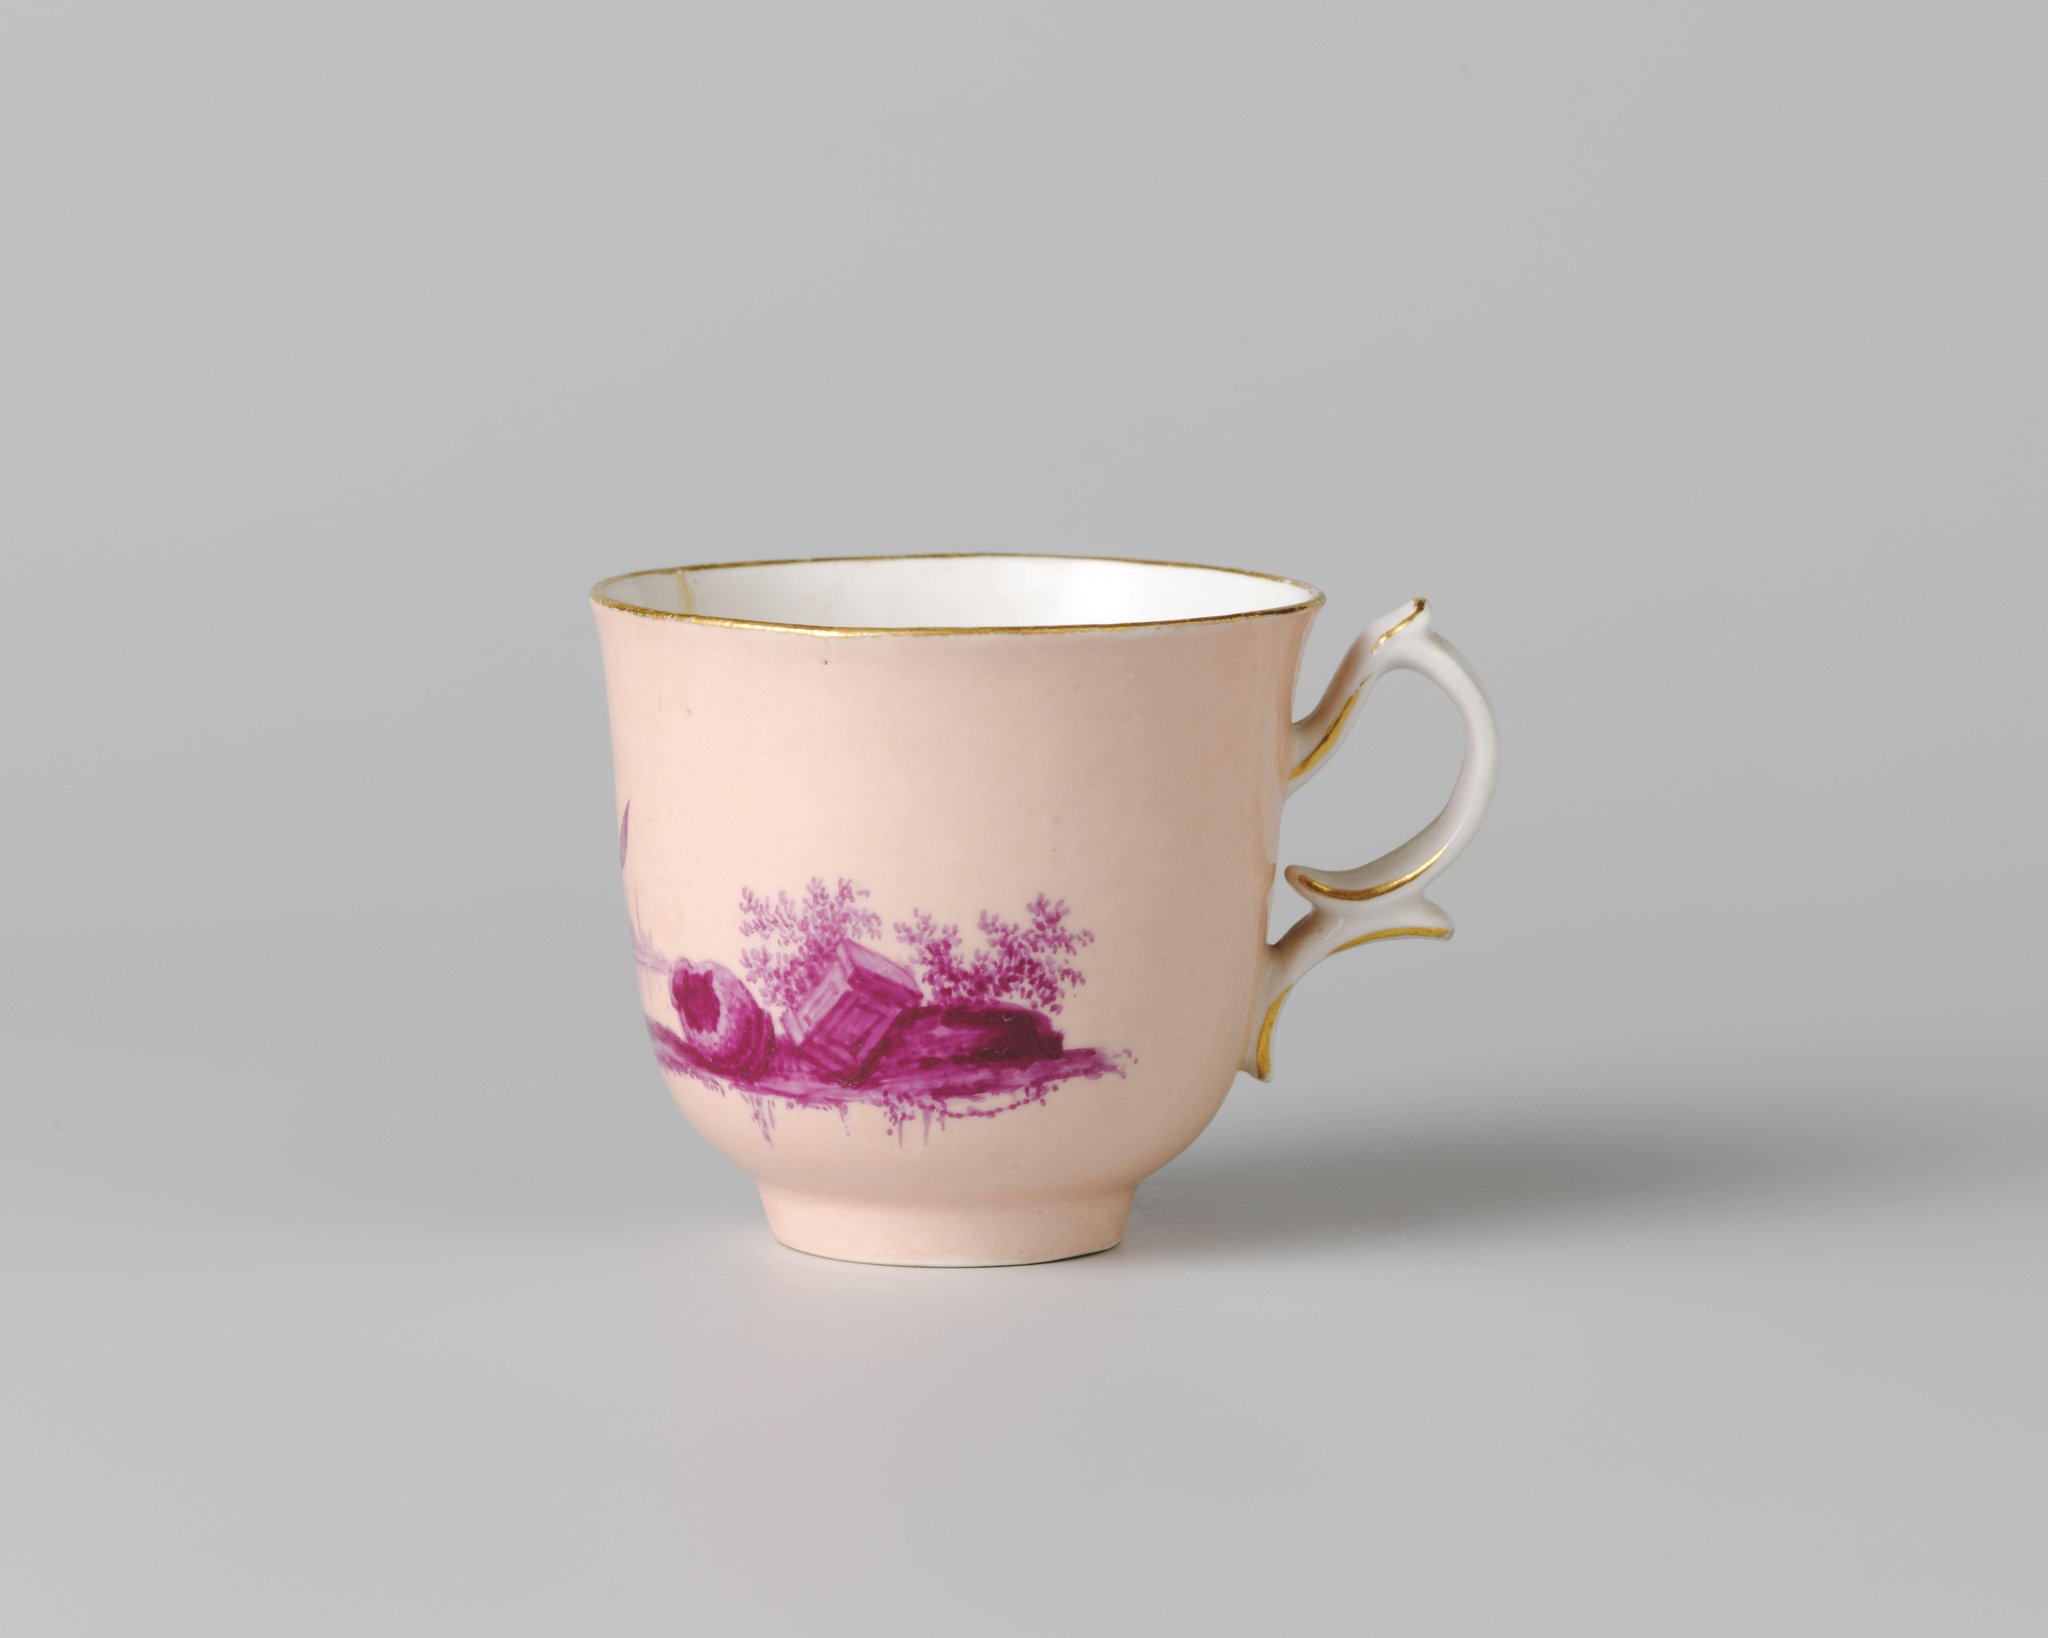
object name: coffee cup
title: Koffiekop van een koffie- en theeservies, beschilderd met figuren in een rivierenlandschap in bietenrood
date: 1774-1778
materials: porcelain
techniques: painted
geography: loosdrecht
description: Parts of a tea and coffee service with pink ground. Porcelain. Loosdrecht, c. 1774 - 1776. Factory of Joannes de Mol.